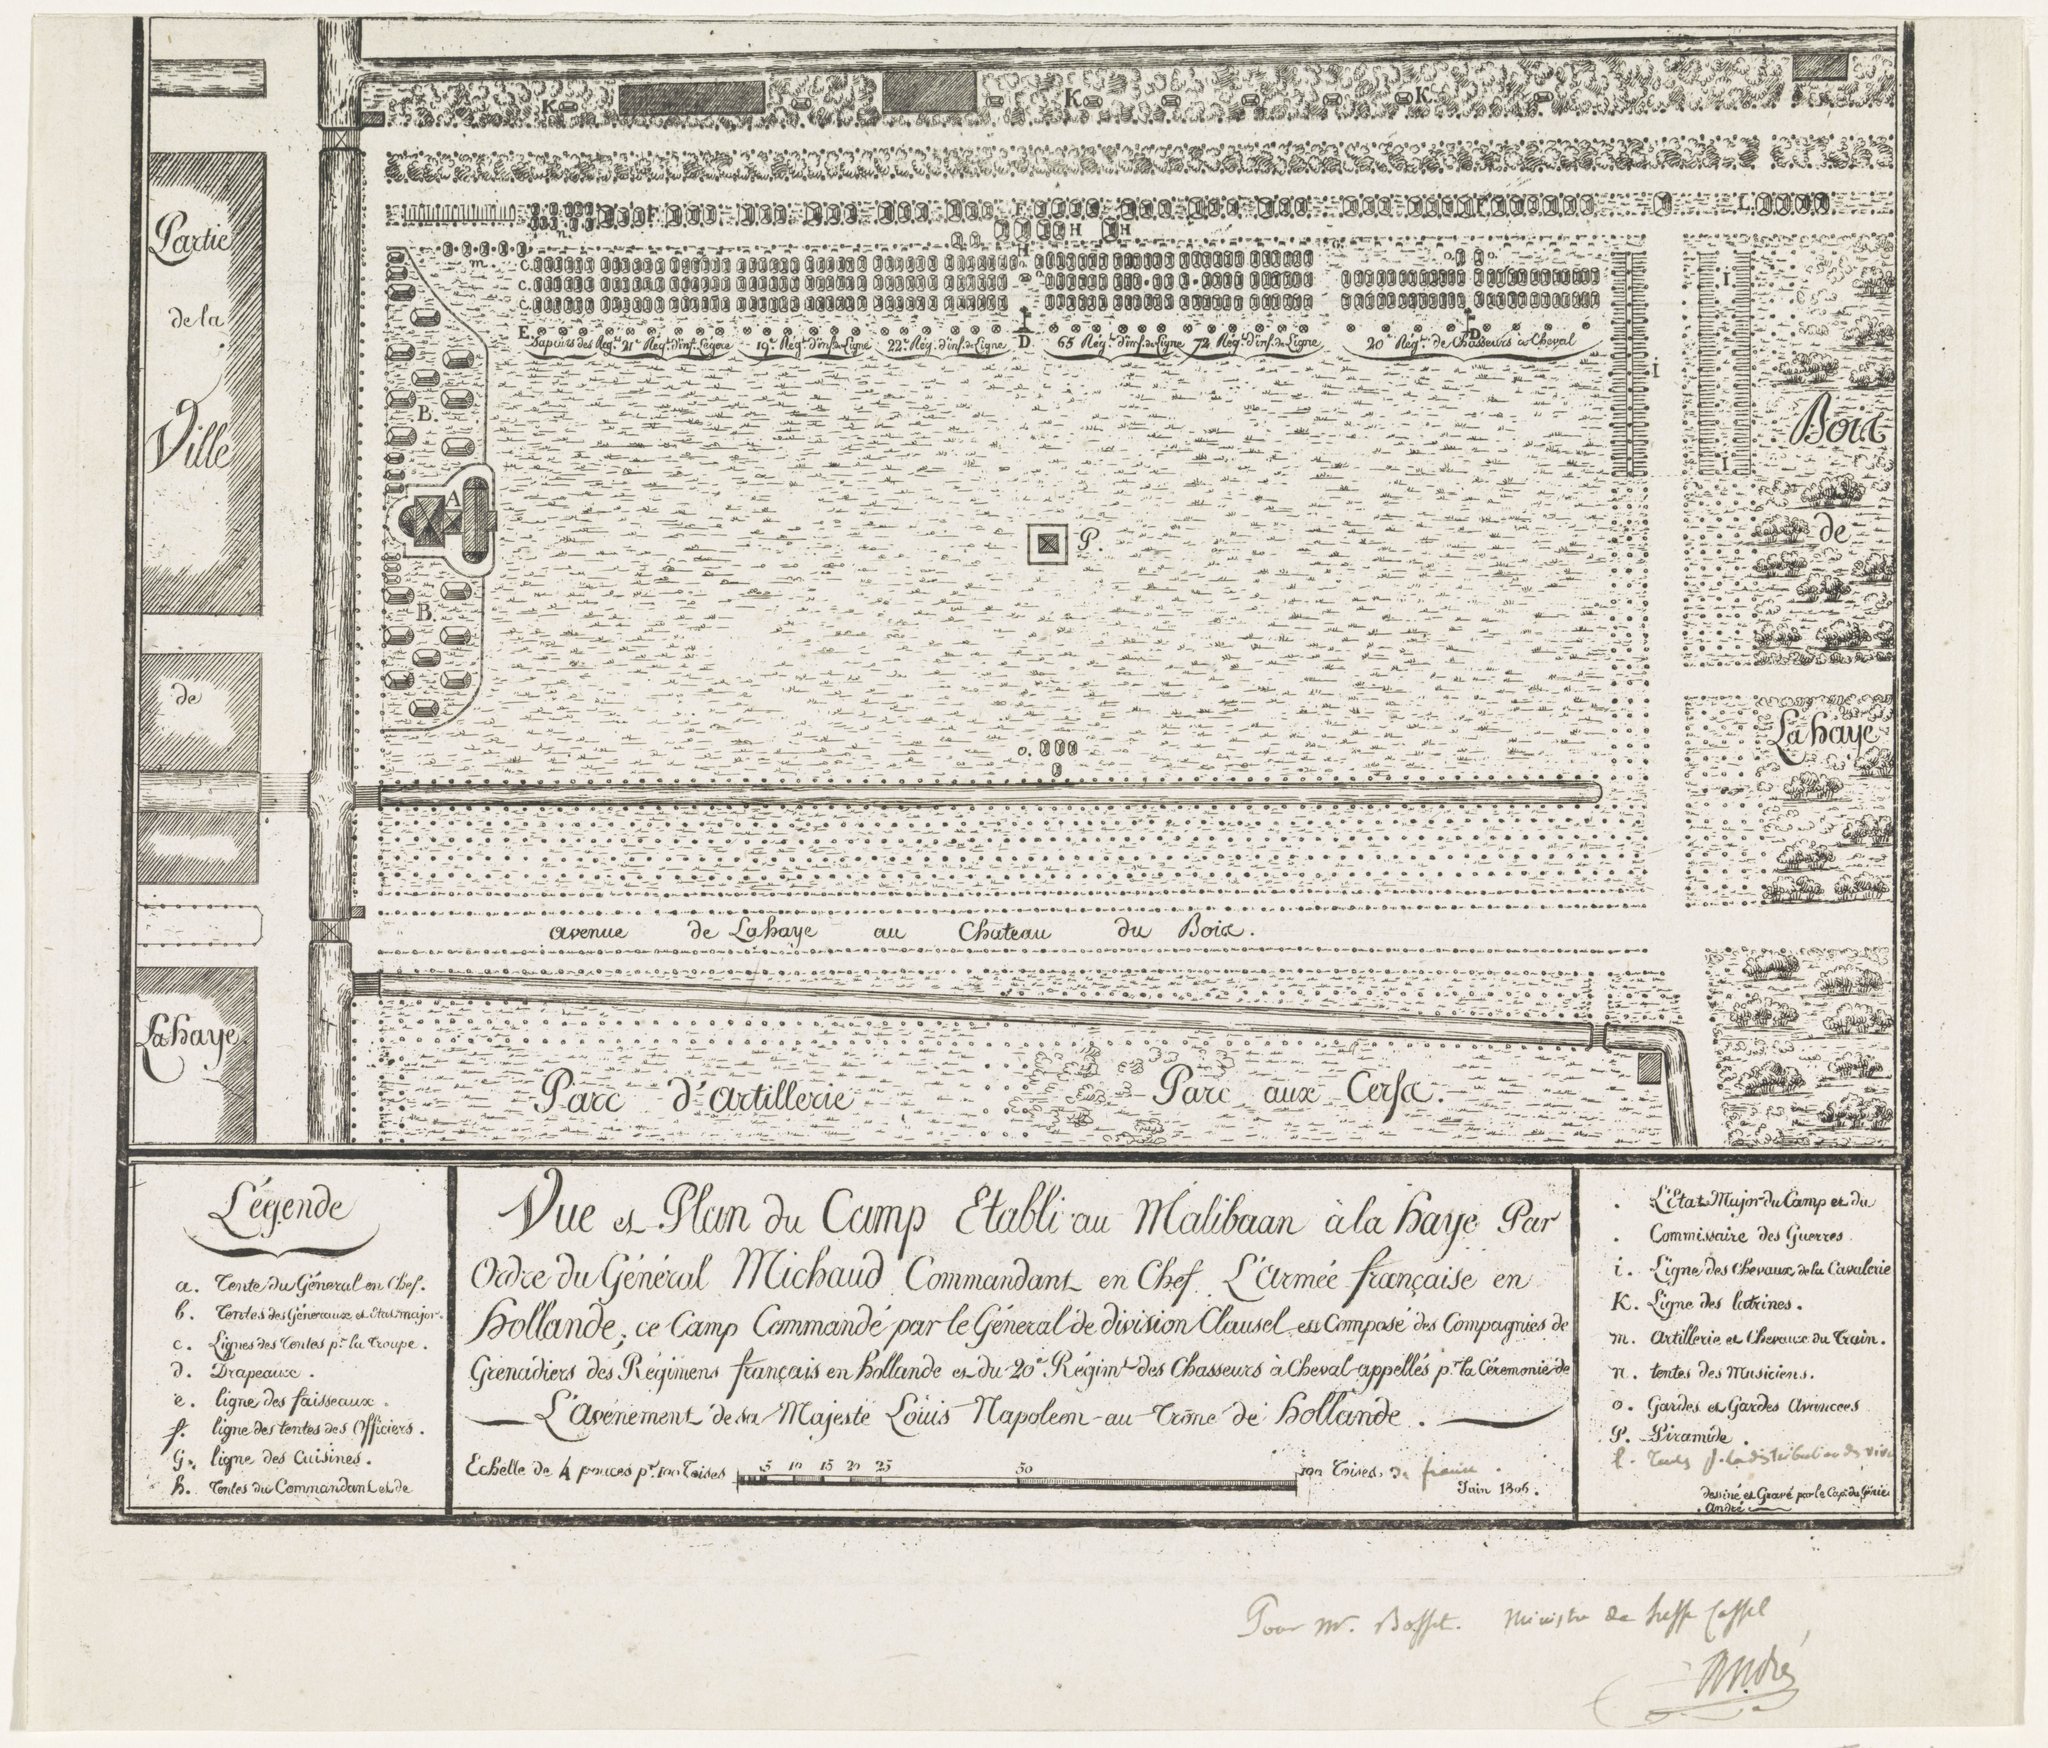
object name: print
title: Vue et Plan du Camp Etabli au Malibaan à la Haye Par Ordre du Général Michaud (...) p.r la Céremonie de L'Avéneement de sa Majesté Louis Napoleon au Crone de Hollande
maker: andré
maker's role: print maker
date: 1806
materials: paper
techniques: etching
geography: the hague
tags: louis napoleon (king of holland), (military) camp with tents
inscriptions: inscription: ‘Por ms. Boffet ... de Hesse Cassel / André’, collector's mark: Lugt 2228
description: Plattegrond van het legerkamp op de Koekamp (naast de Maliebaan) te Den Haag, opgericht op last van generaal Michaud ter gelegenheid van de ontvangst van Lodewijk Napoleon, juni 1806. In het onderschrift de legenda a-p in het Frans. Bij de plattegrond behoort ook een gezicht op het kamp.